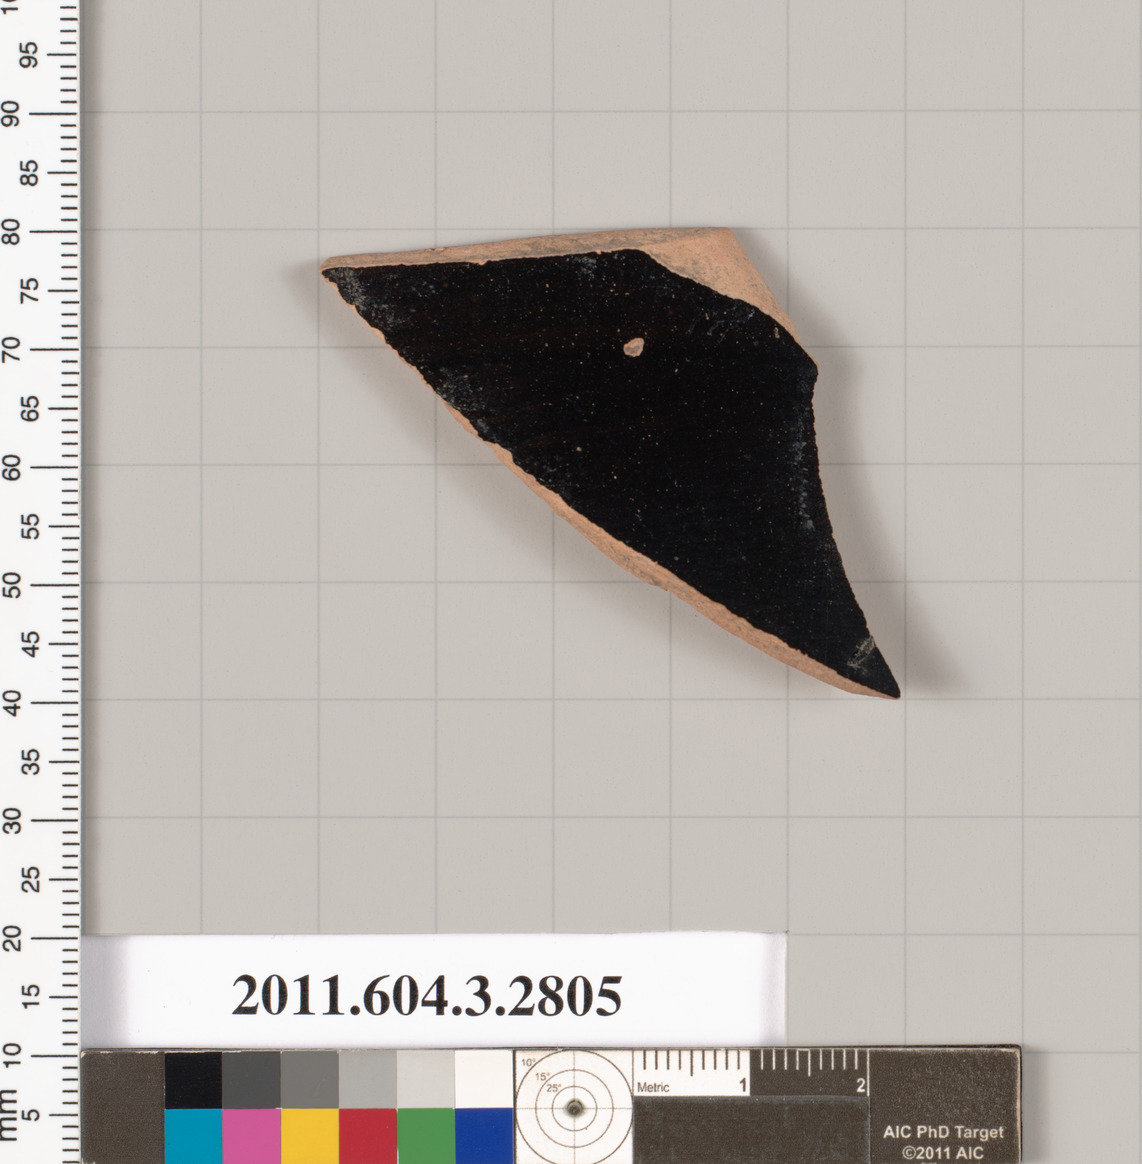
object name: olpe fragment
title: Terracotta fragment of an olpe (jug)?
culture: greek, attic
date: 600-401 BCE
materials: terracotta